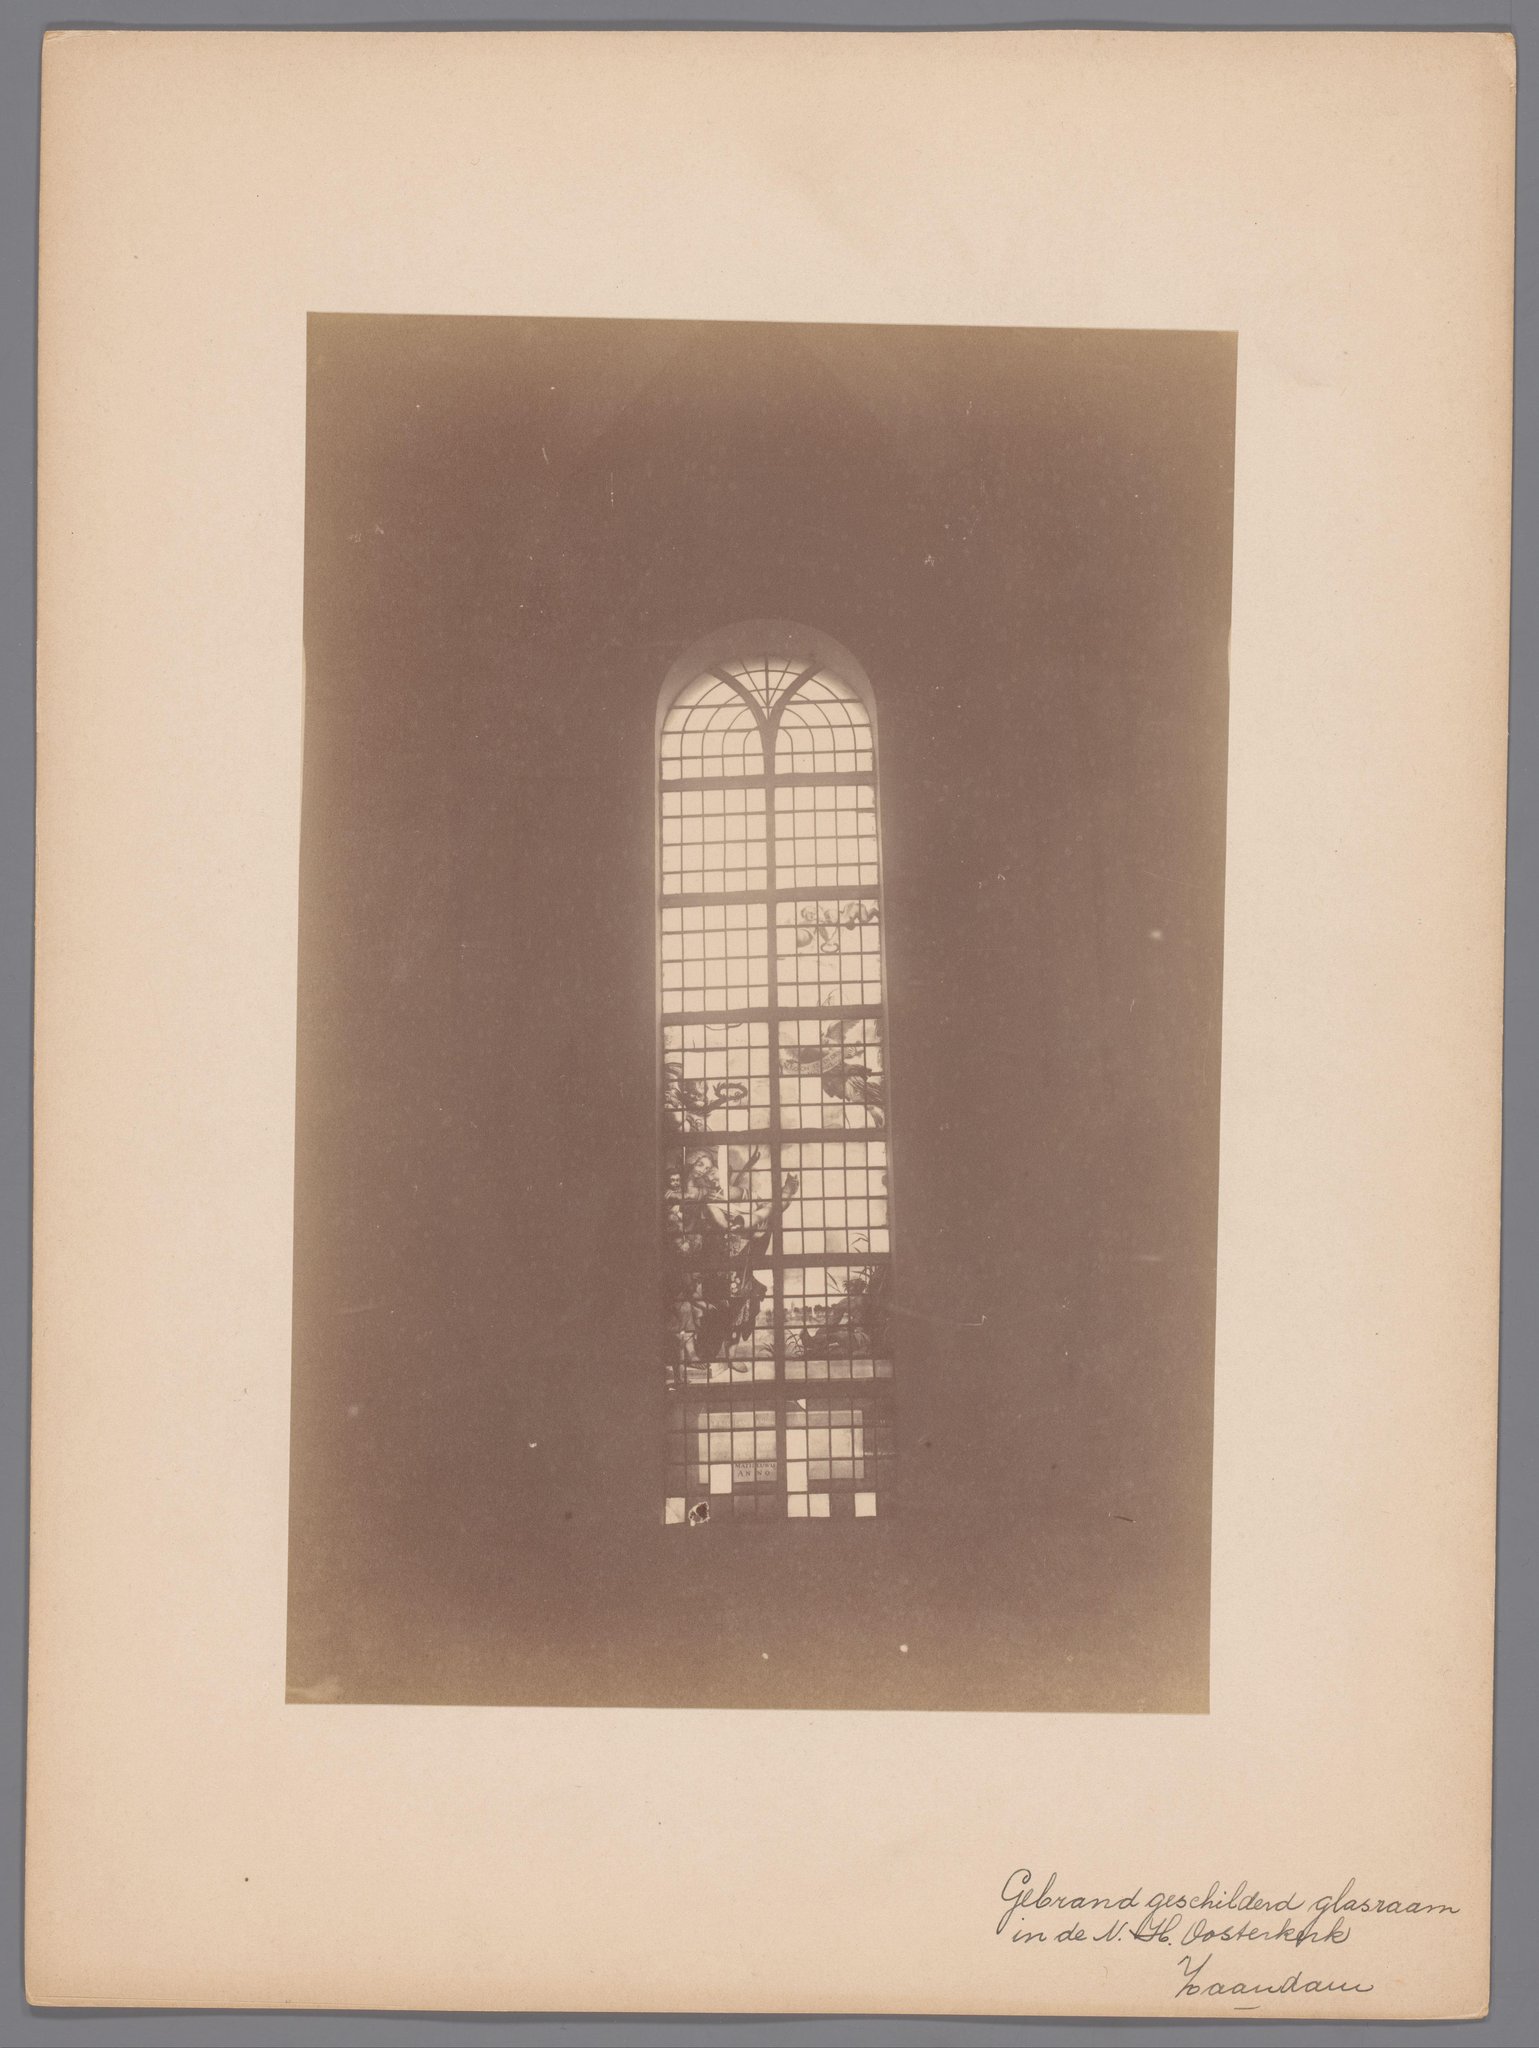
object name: photograph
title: Geschilderd raam in de Nederlands-hervormde Oosterkerk te Zaandam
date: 1890-1910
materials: cardboard, photographic support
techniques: albumen print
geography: oosterkerk zaandam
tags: church-window, e.g. rose-window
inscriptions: annotation: ‘Gebrand geschilderd glasraam in de N.H. Oosterkerk/ Zaandam’, annotation: ‘Gebrand geschilderd glasraam in de Oosterkerk te Zaandam’